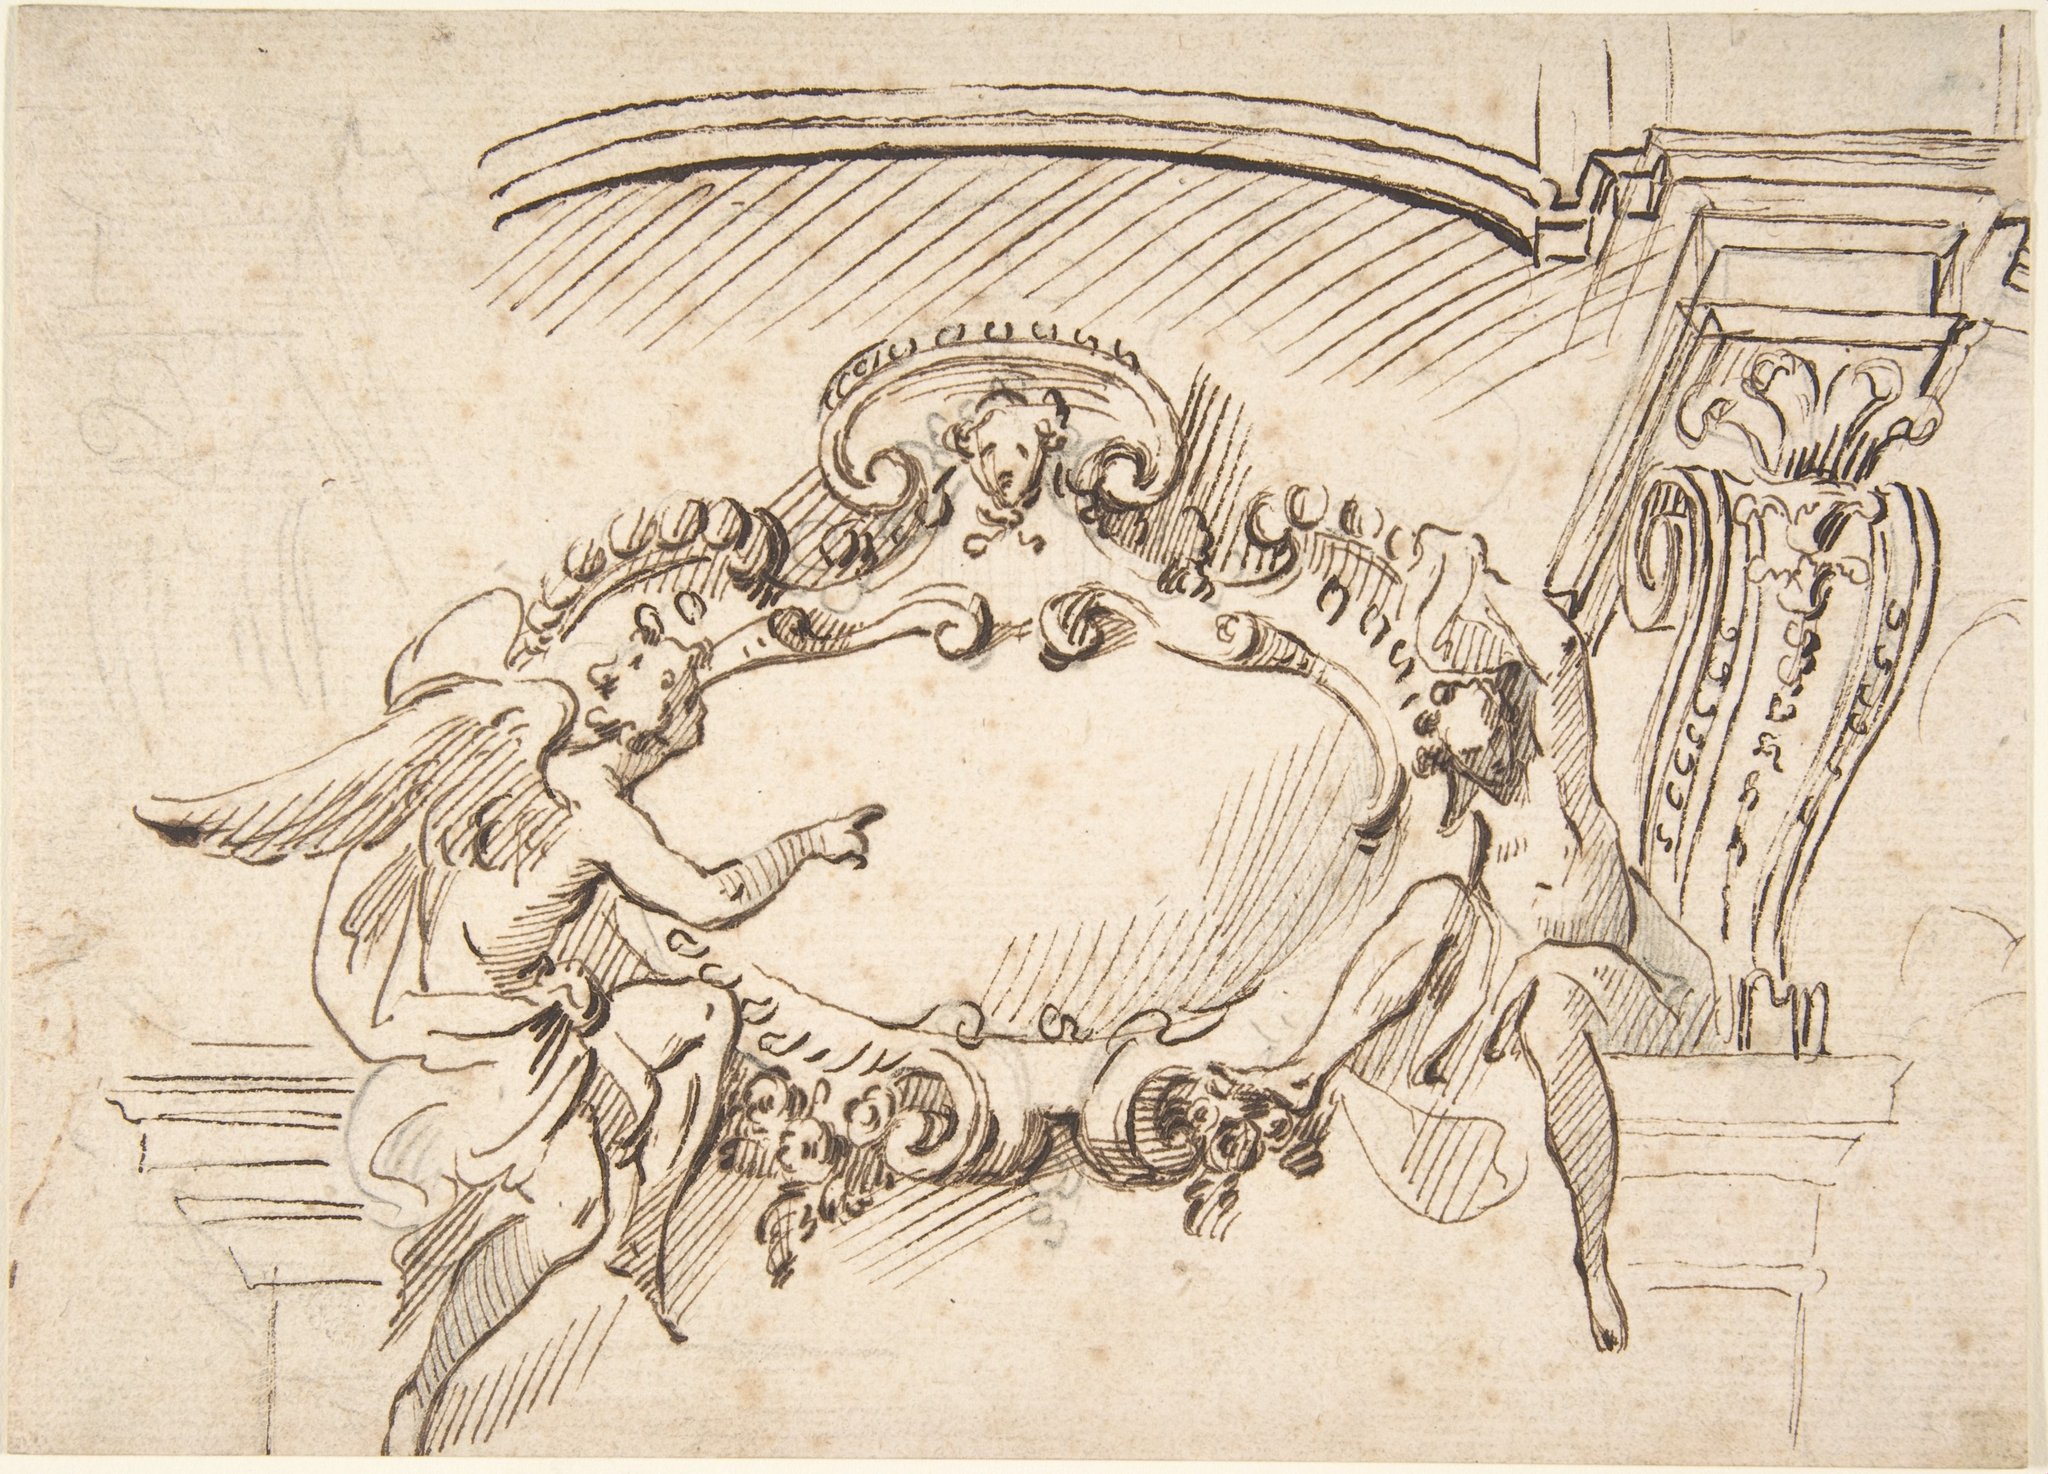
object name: drawing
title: Design with a Cartouche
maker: anonymous, french, 19th century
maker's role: artist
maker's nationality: french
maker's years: 1800-1900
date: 1801-1900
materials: graphite, ink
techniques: pen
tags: cartouches